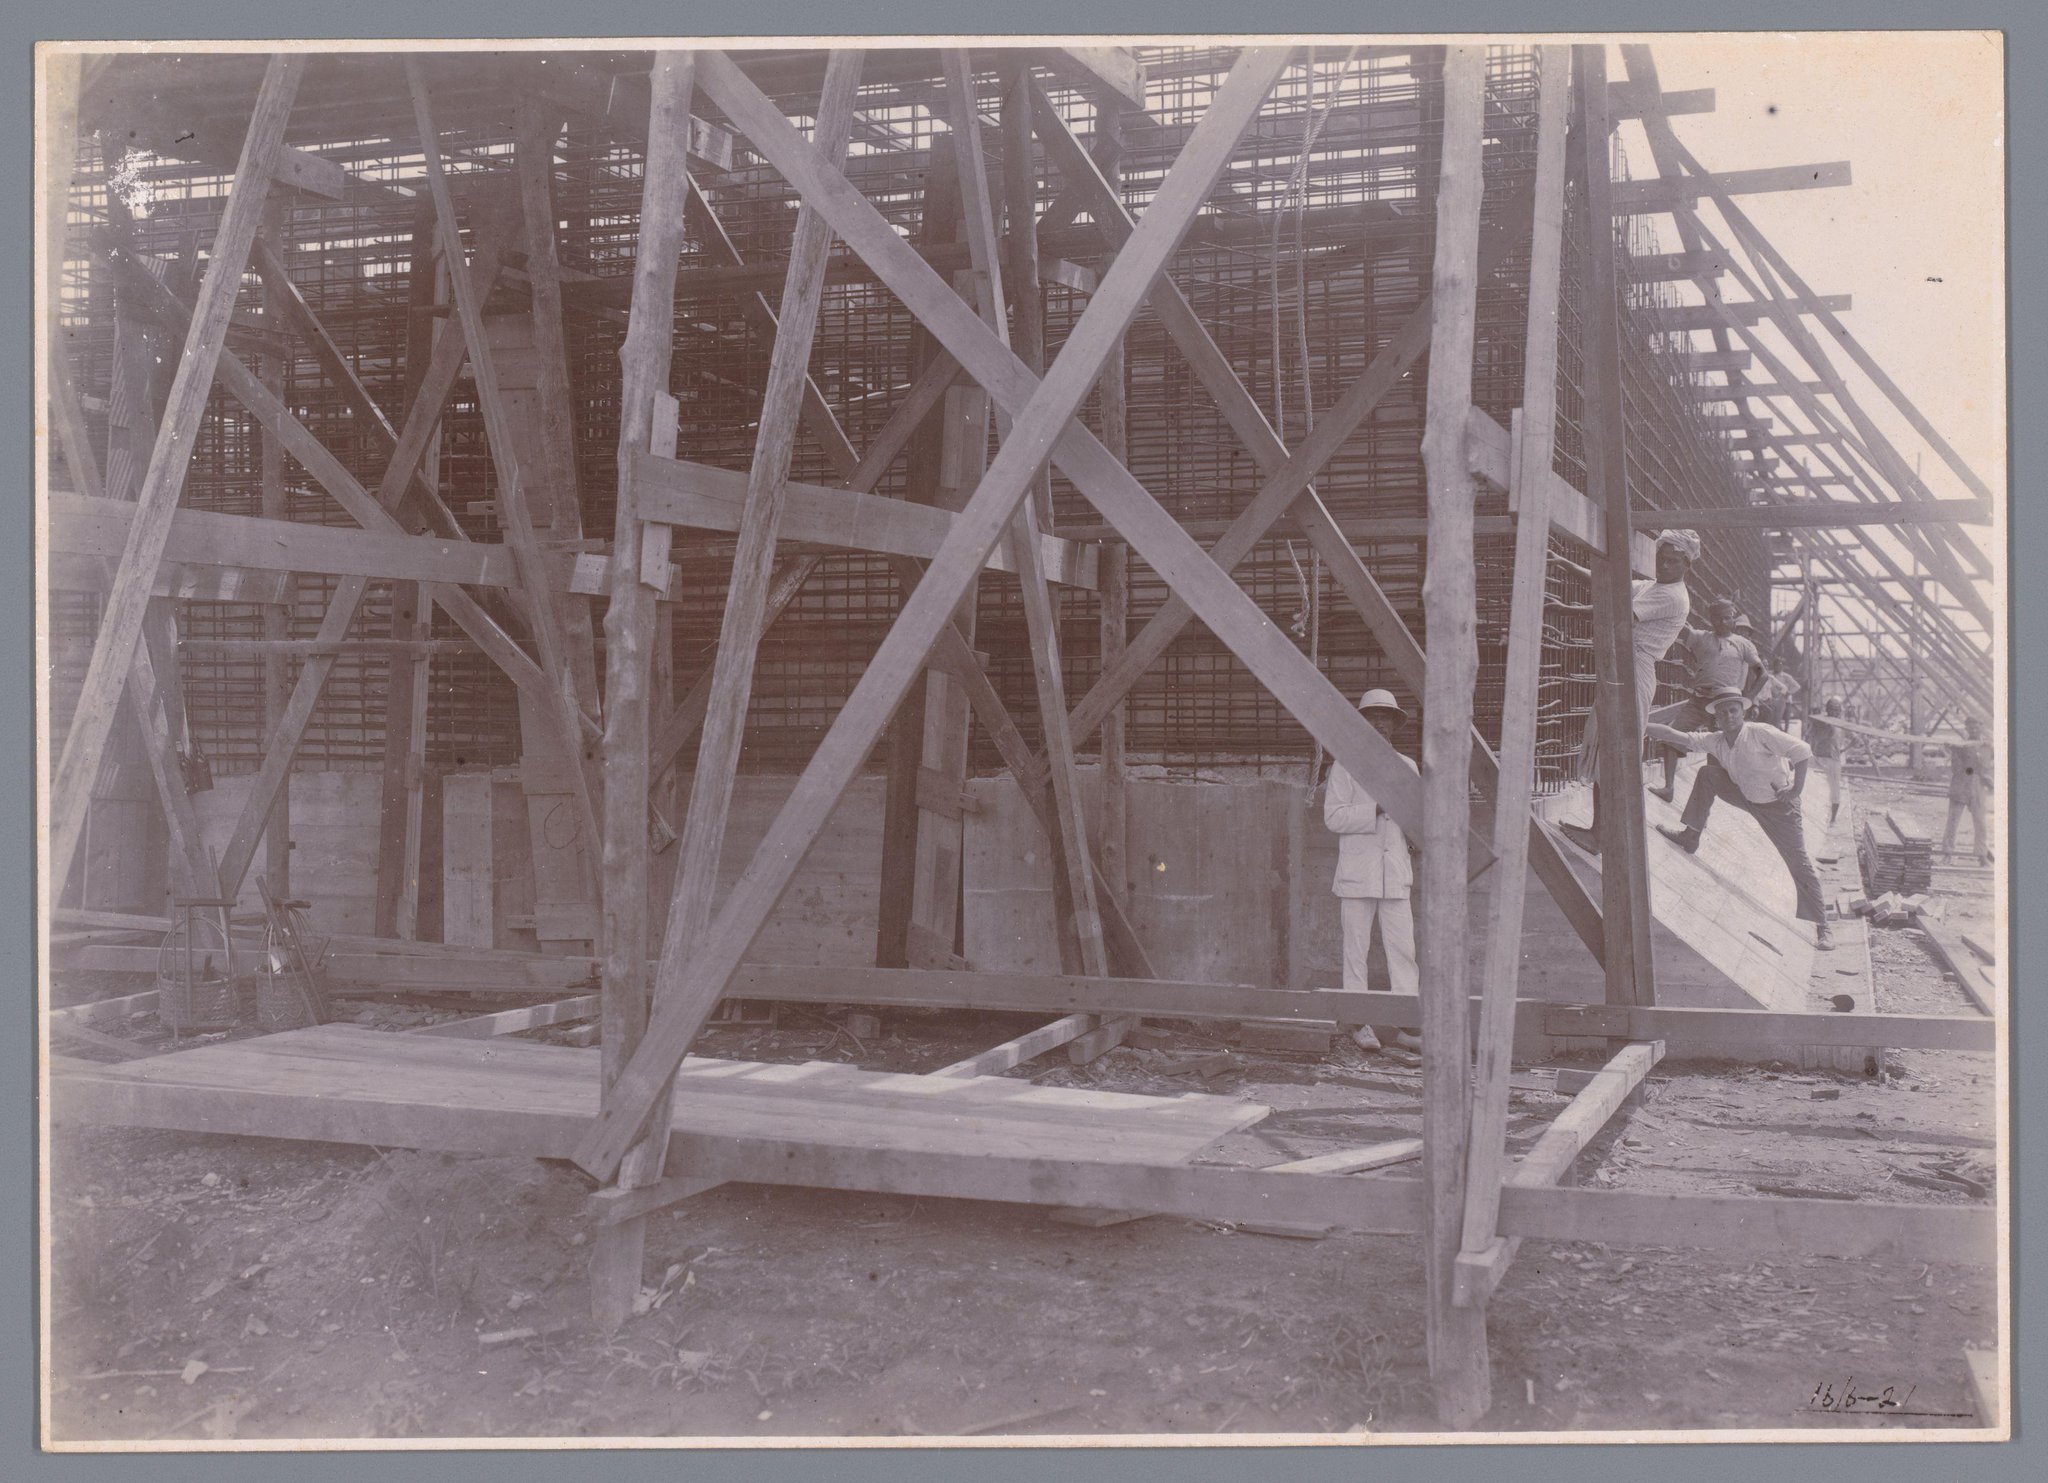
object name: photograph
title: Oceaanhaven Belawan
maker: Anonymous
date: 1921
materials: photographic support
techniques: gelatin silver print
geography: belawan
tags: harbour, building-site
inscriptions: date: ‘16/6-21’, inscription: ‘No. 21 Oceaanhaven Belawan / Caisson No 1’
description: Bouwterrein met caisson in constructie. Genummerd: 21. Onderdeel van de groep van losse foto's over de aanleg van de haven Belawan aan de kust voor Medan, Sumatra 1921-1922.